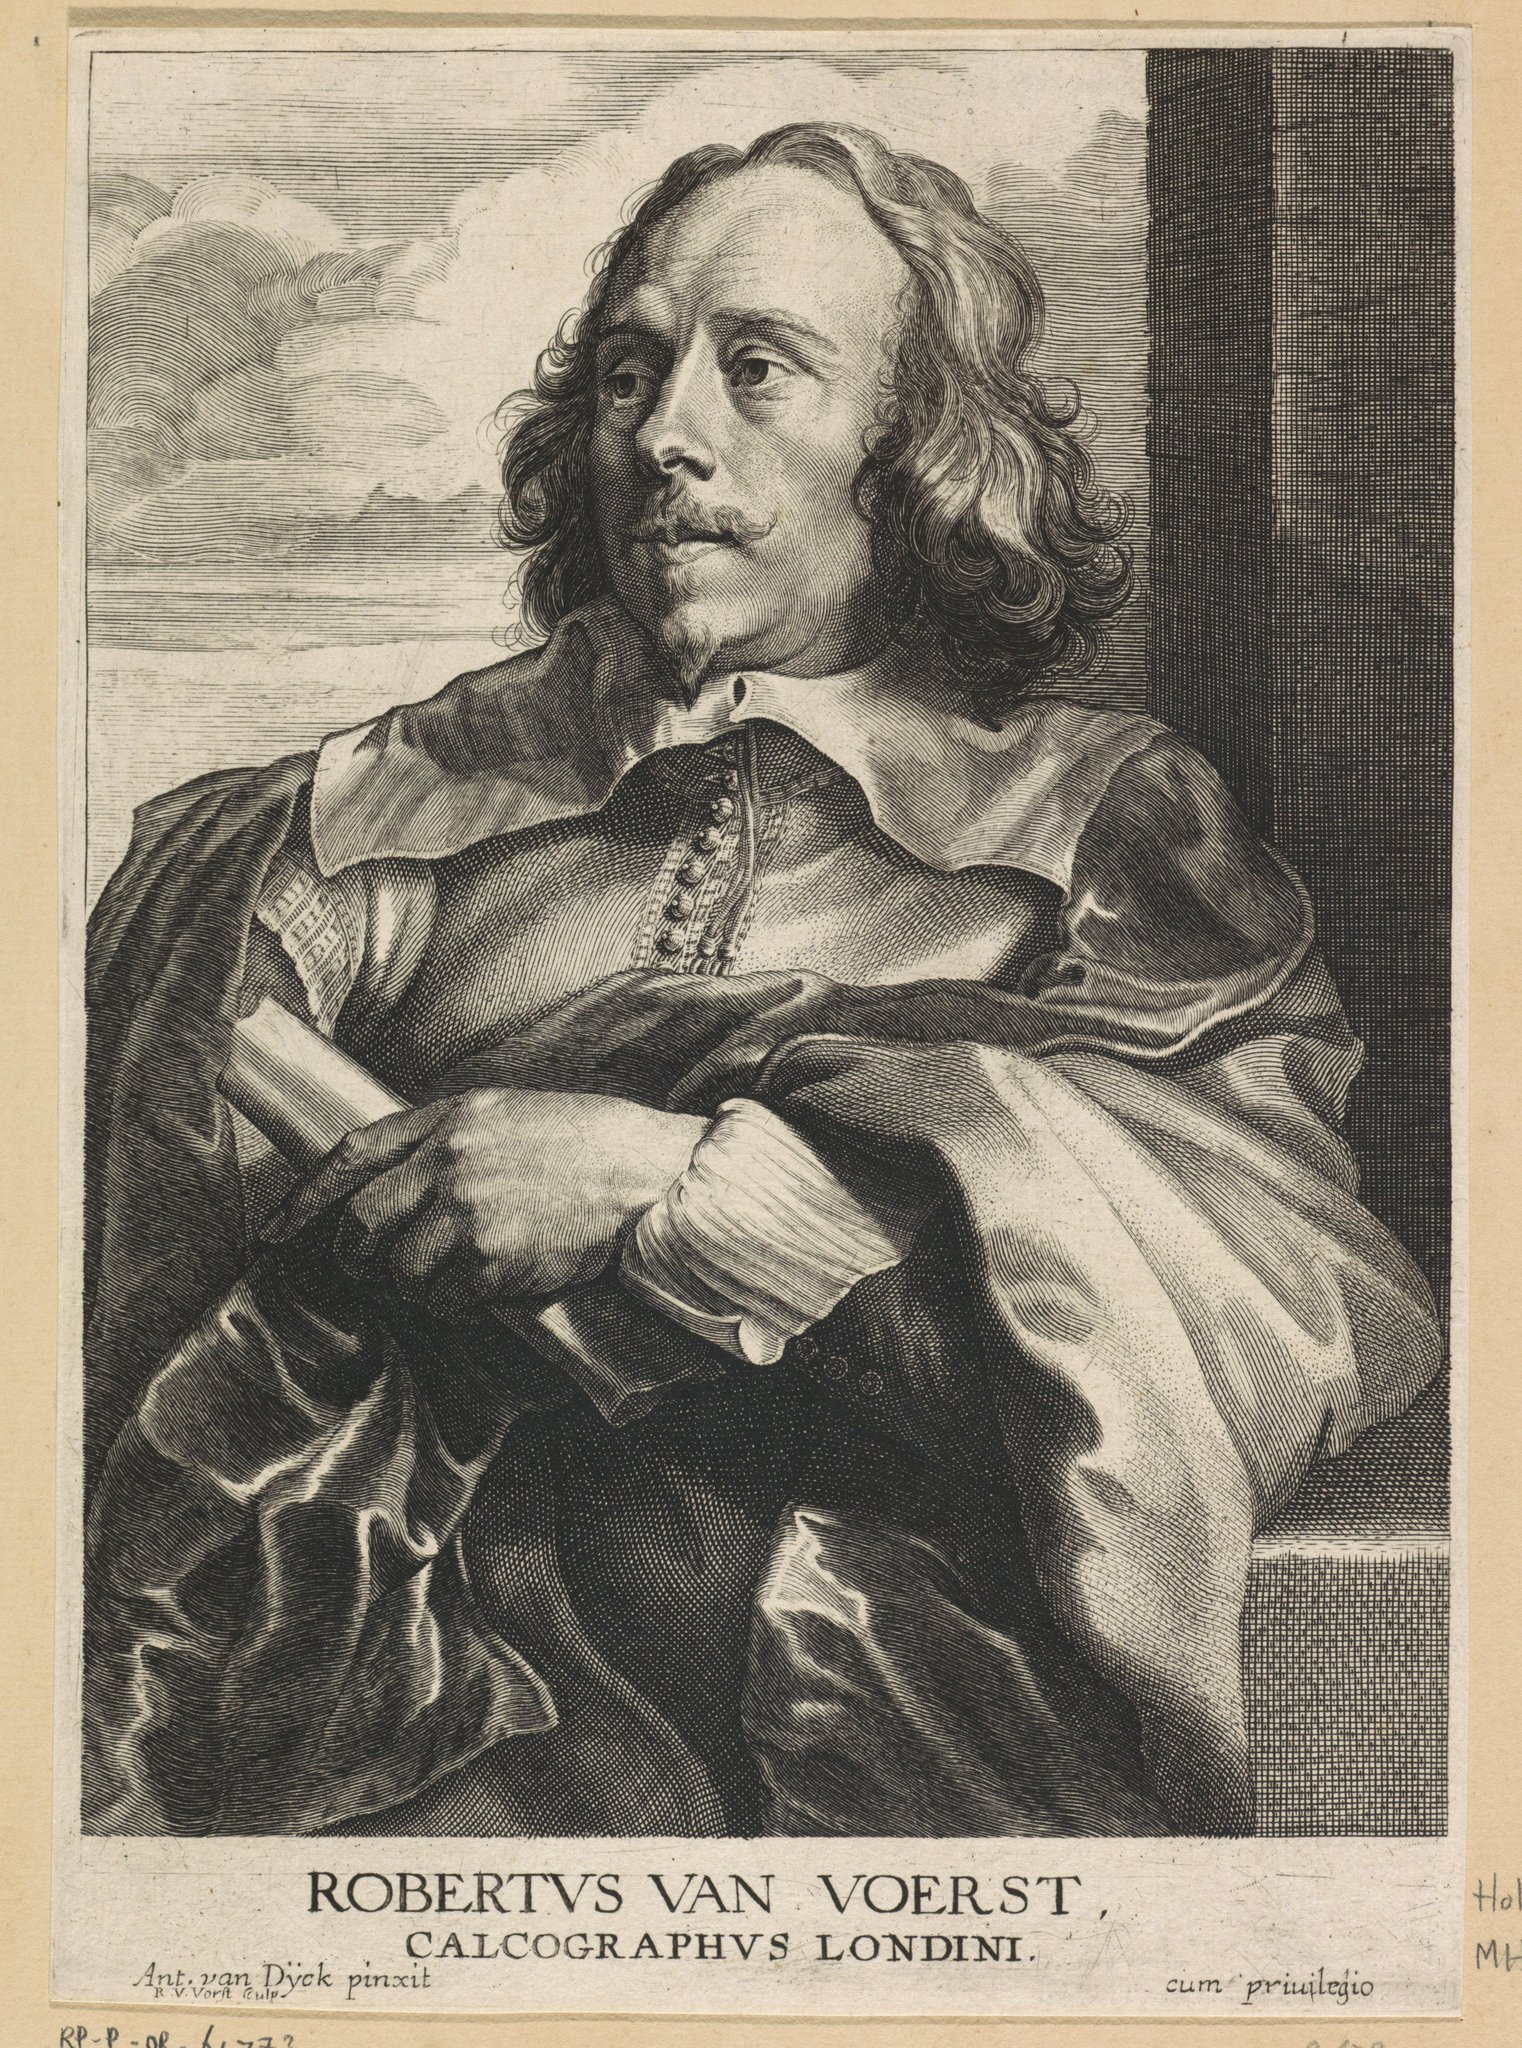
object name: print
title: Portret van Robert van Voerst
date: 1627-1636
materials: paper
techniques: engraving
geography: london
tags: deventer, london, print maker, robert van voerst, paper (writing material)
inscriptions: collector's mark: Lugt 240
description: Portet van de graveur Robert van Voerst. In zijn hand een rol papier.